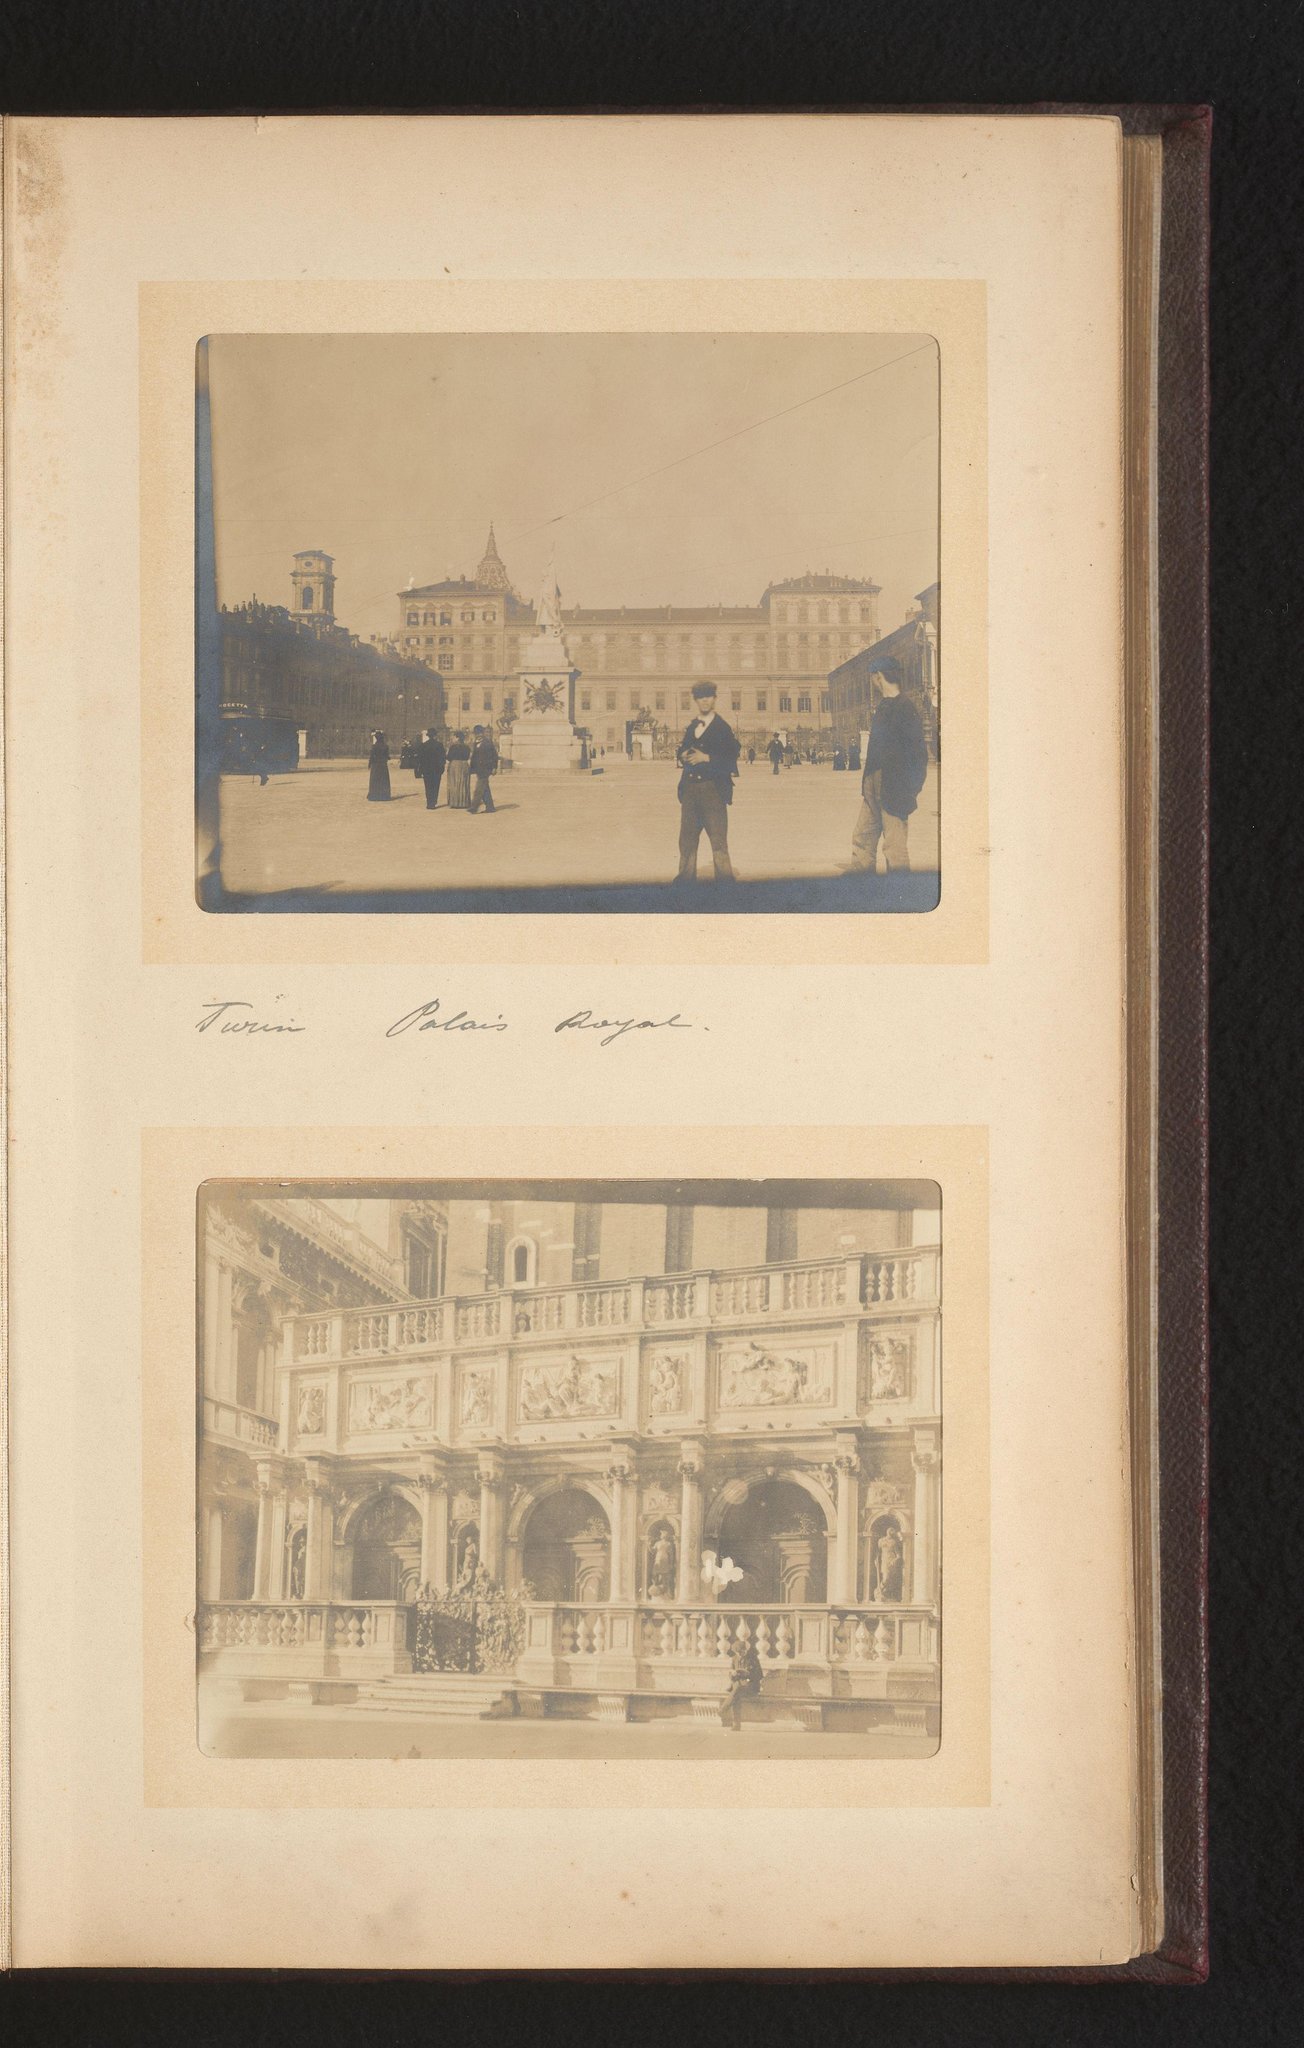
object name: photograph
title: Koninklijk Paleis en een boog of oxaal in Turijn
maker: Anonymous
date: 1895-1905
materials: cardboard, photographic support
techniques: gelatin silver print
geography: turin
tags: tourism, square, place, circus, etc. (+ city(-scape) with figures, staffage)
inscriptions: inscription: ‘Turin Palais Royal’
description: Albumblad met twee foto's van Turijn. Onderdeel van een fotoalbum van een reis door Italië, ca. 1900.